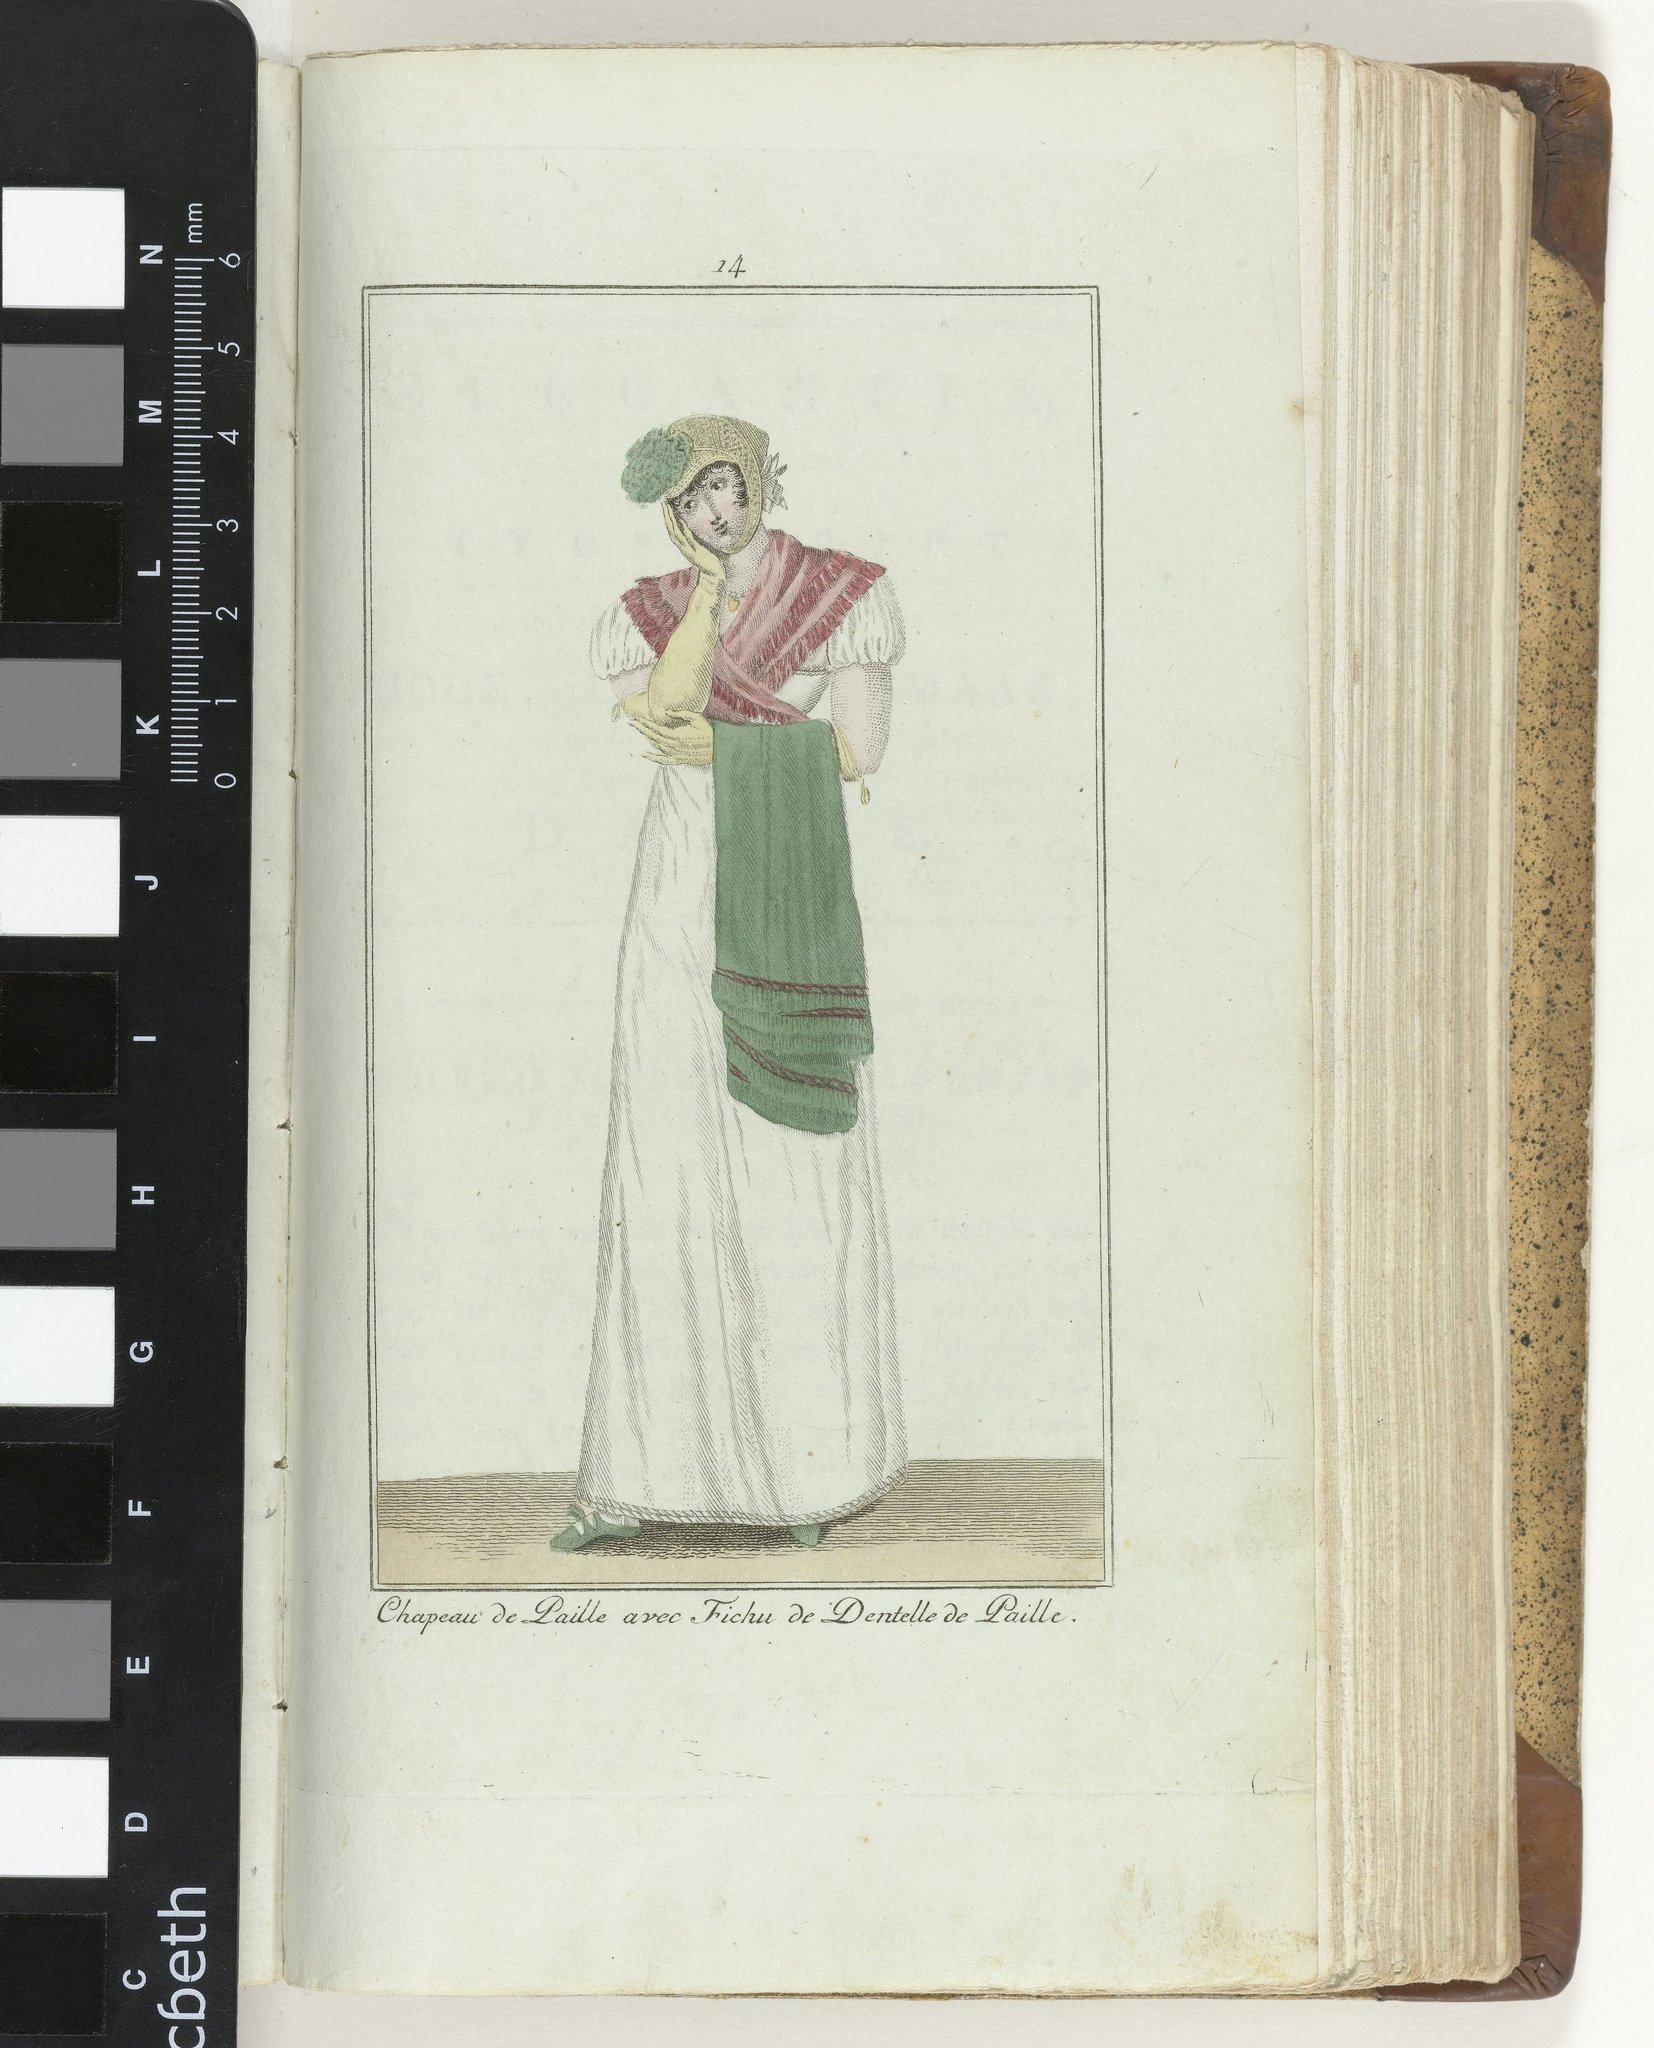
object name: magazine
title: Elegantia, of tijdschrift van mode, luxe en smaak voor dames, Juni 1807, No. 14: Chapeau de Paille...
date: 1807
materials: paper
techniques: engraving, hand coloring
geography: amsterdam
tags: gloves, mittens (long gloves) (+ women's clothes), clothing for the upper part of the body (shawl) (+ women's clothes), head-gear (straw hat) (+ women's clothes), fashion plates, shoes, sandals (+ women's clothes), dress, gown (+ women's clothes), piece of clothing covering the breast or décolleté (fichu) (+ women's clothes)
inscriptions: caption: ‘Chapeau de Paille avec Fichu de Dentelle de Paille’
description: Volgens de begeleidende tekst (p. 200): Japon van mousseline. Strohoed gegarneerd met stro. 'Fichu Turc'. Sjaal, schoenen en 'touffe' op de strohoed van groene kasjmier. Prent uit het modetijdschrift Elegantia, of tijdschrift van mode, luxe en smaak voor dames 1807-1814 (onderbroken door de periode 1811-1813).